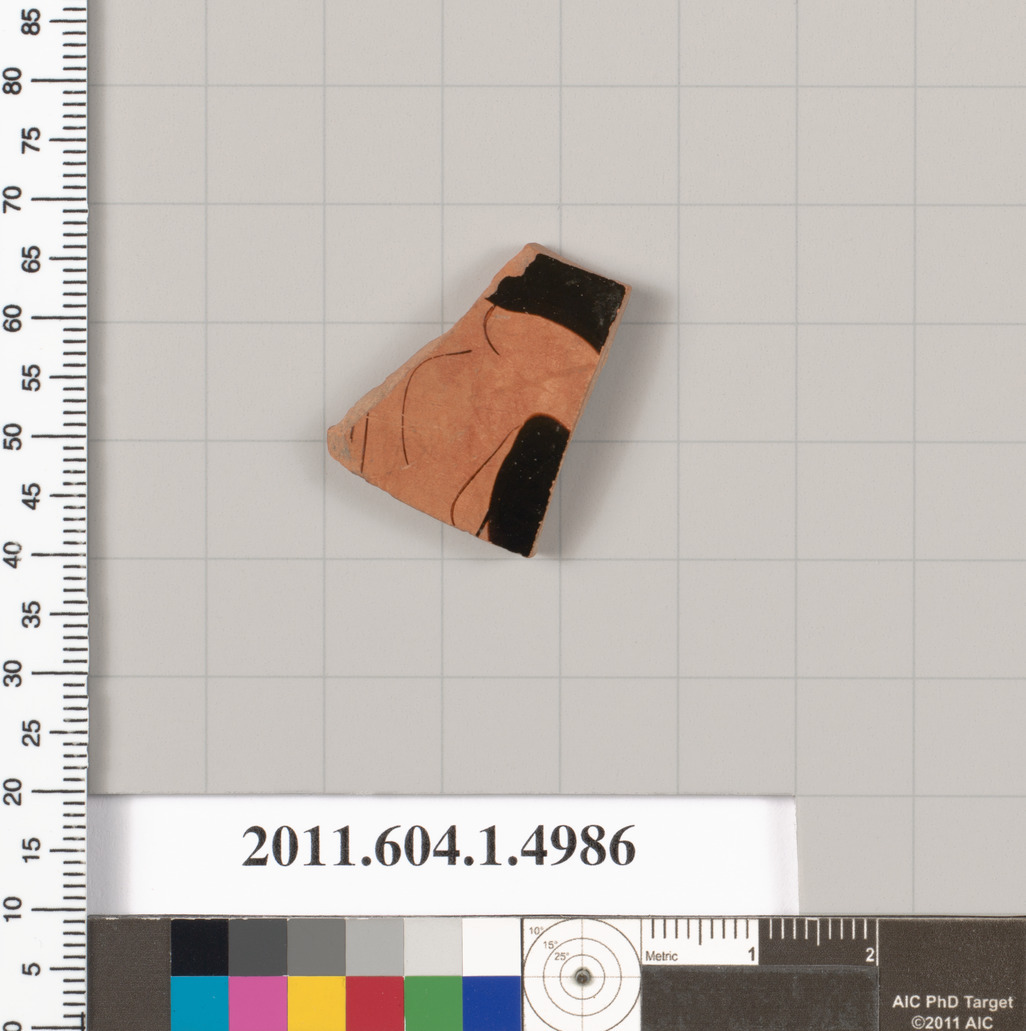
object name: kylix fragment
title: Terracotta fragment of a kylix (drinking cup)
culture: greek, attic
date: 475-451 BCE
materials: terracotta